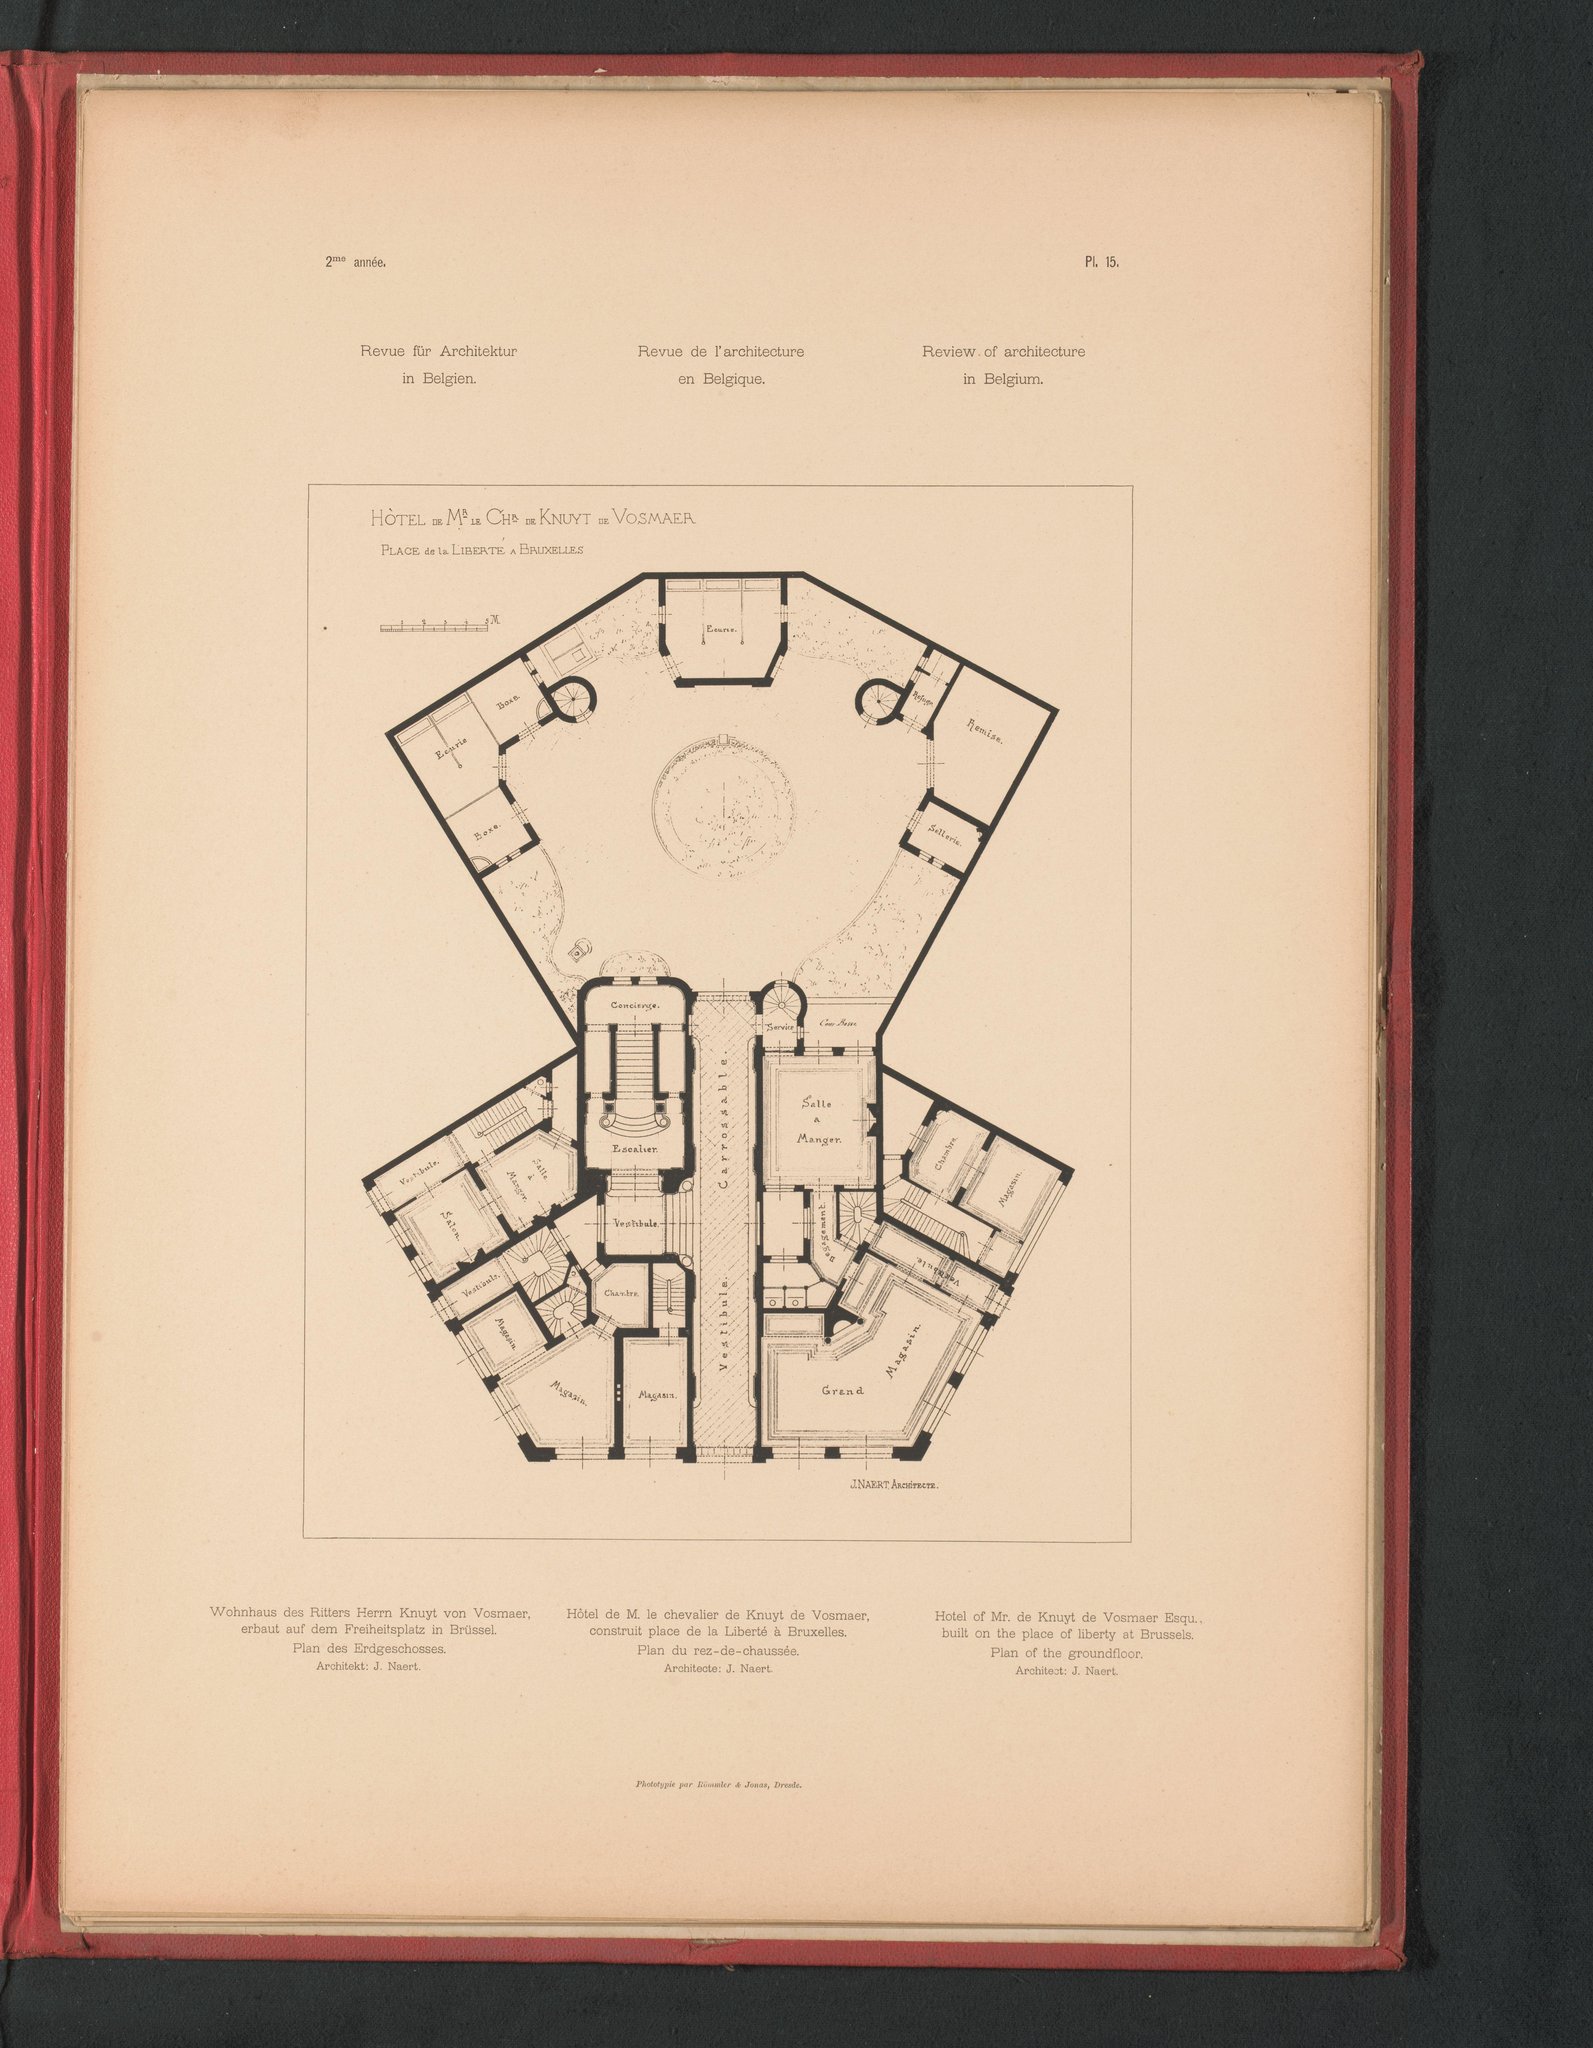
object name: reproduction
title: Wohnhaus des Ritters Herrn Knuyt von Vosmaer, erbaut auf dem Freiheitsplatz in Brüssel. Plan des Erdgeschosses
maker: joseph naert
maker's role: architect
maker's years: 1838-1910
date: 1888-1893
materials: paper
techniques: photograph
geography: dresden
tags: plan ~ architecture, civic architecture; edifices; dwellings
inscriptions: number: ‘Pl. 15.’, inscription: ‘2me. année.’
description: Deze prent maakt deel uit van een omslag met 110 prenten op 90 bladen en 18 tekstbladen.